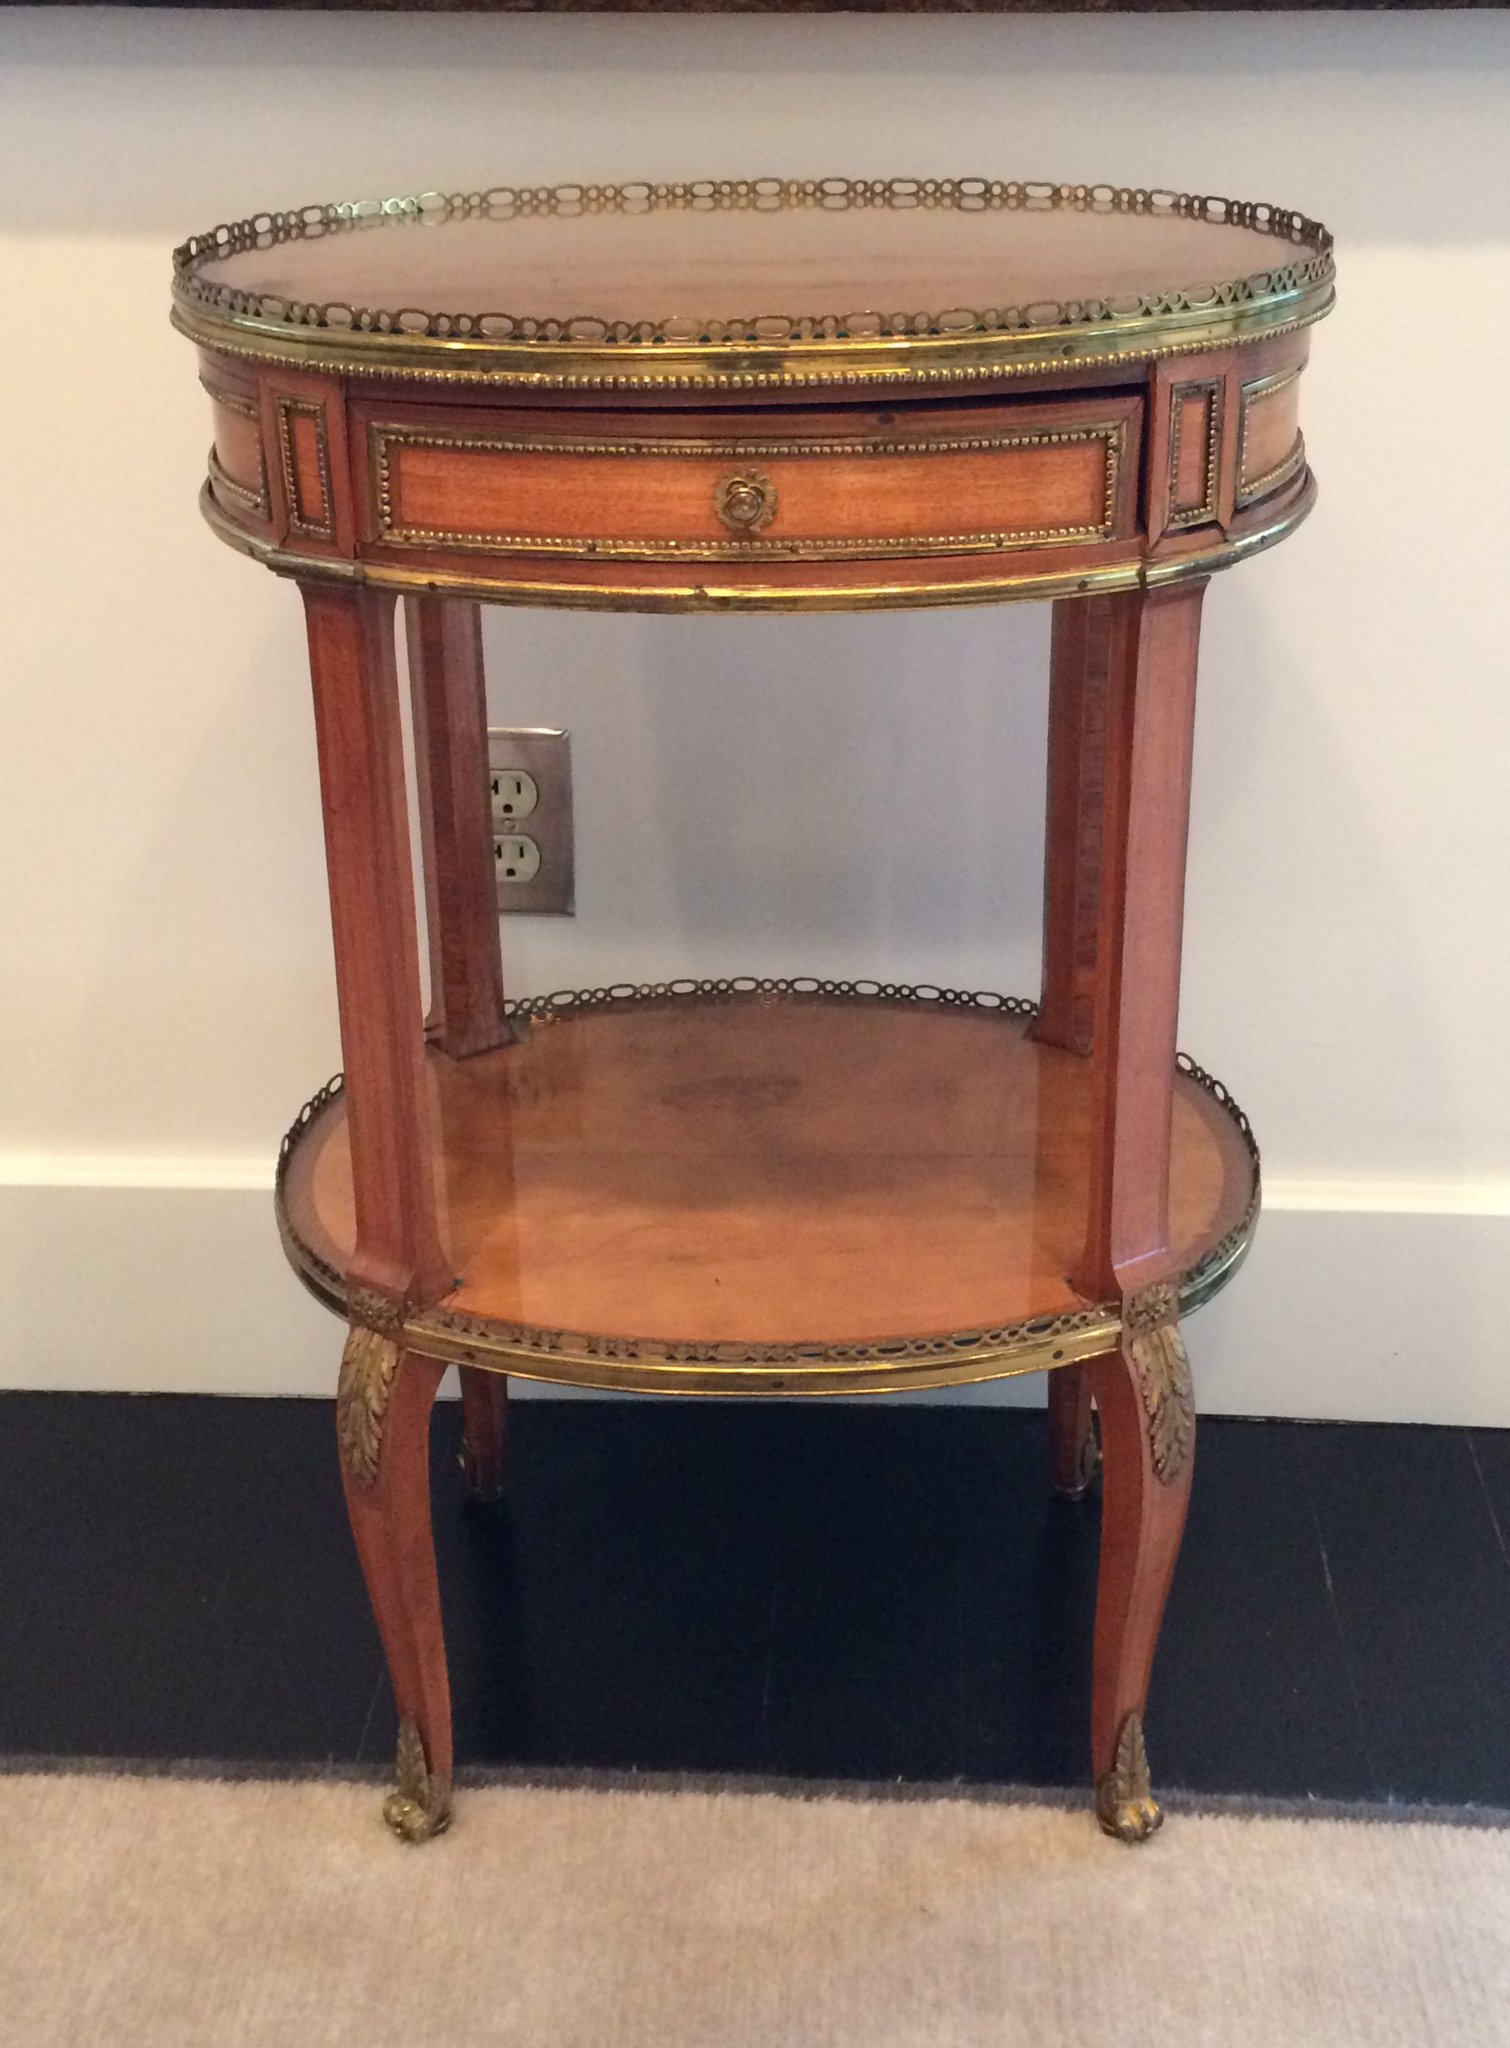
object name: table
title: Small oval table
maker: claude-charles saunier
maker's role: maker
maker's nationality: french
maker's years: 1735-1807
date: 1775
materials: wood